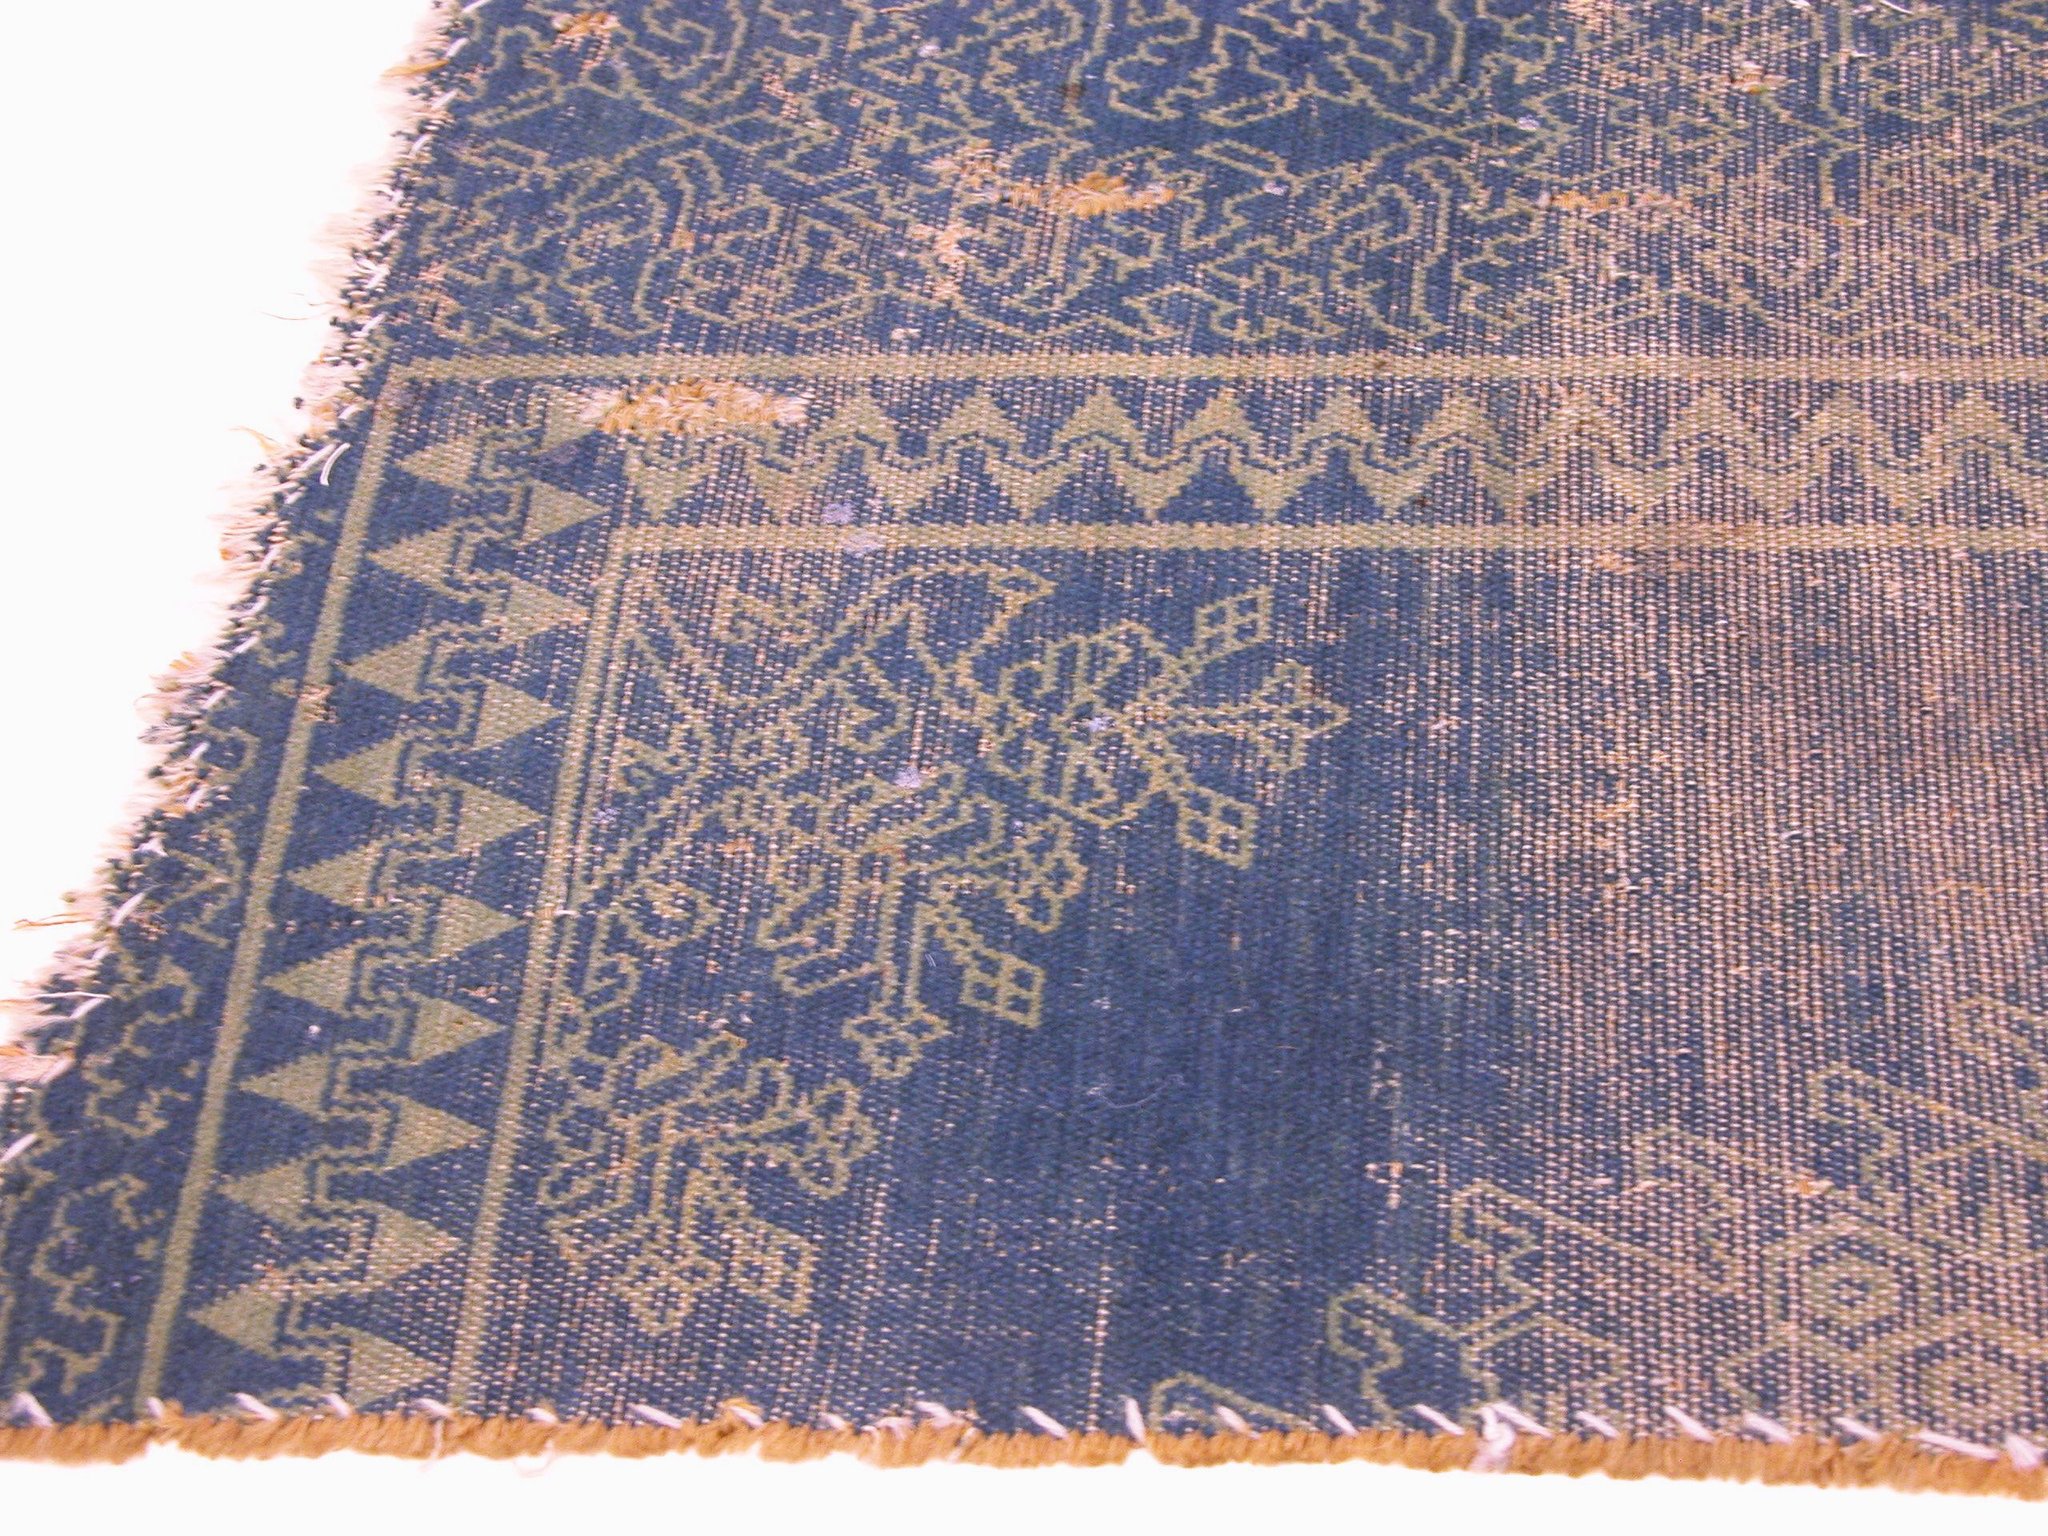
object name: carpet fragment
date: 1501-1600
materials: wool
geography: spain